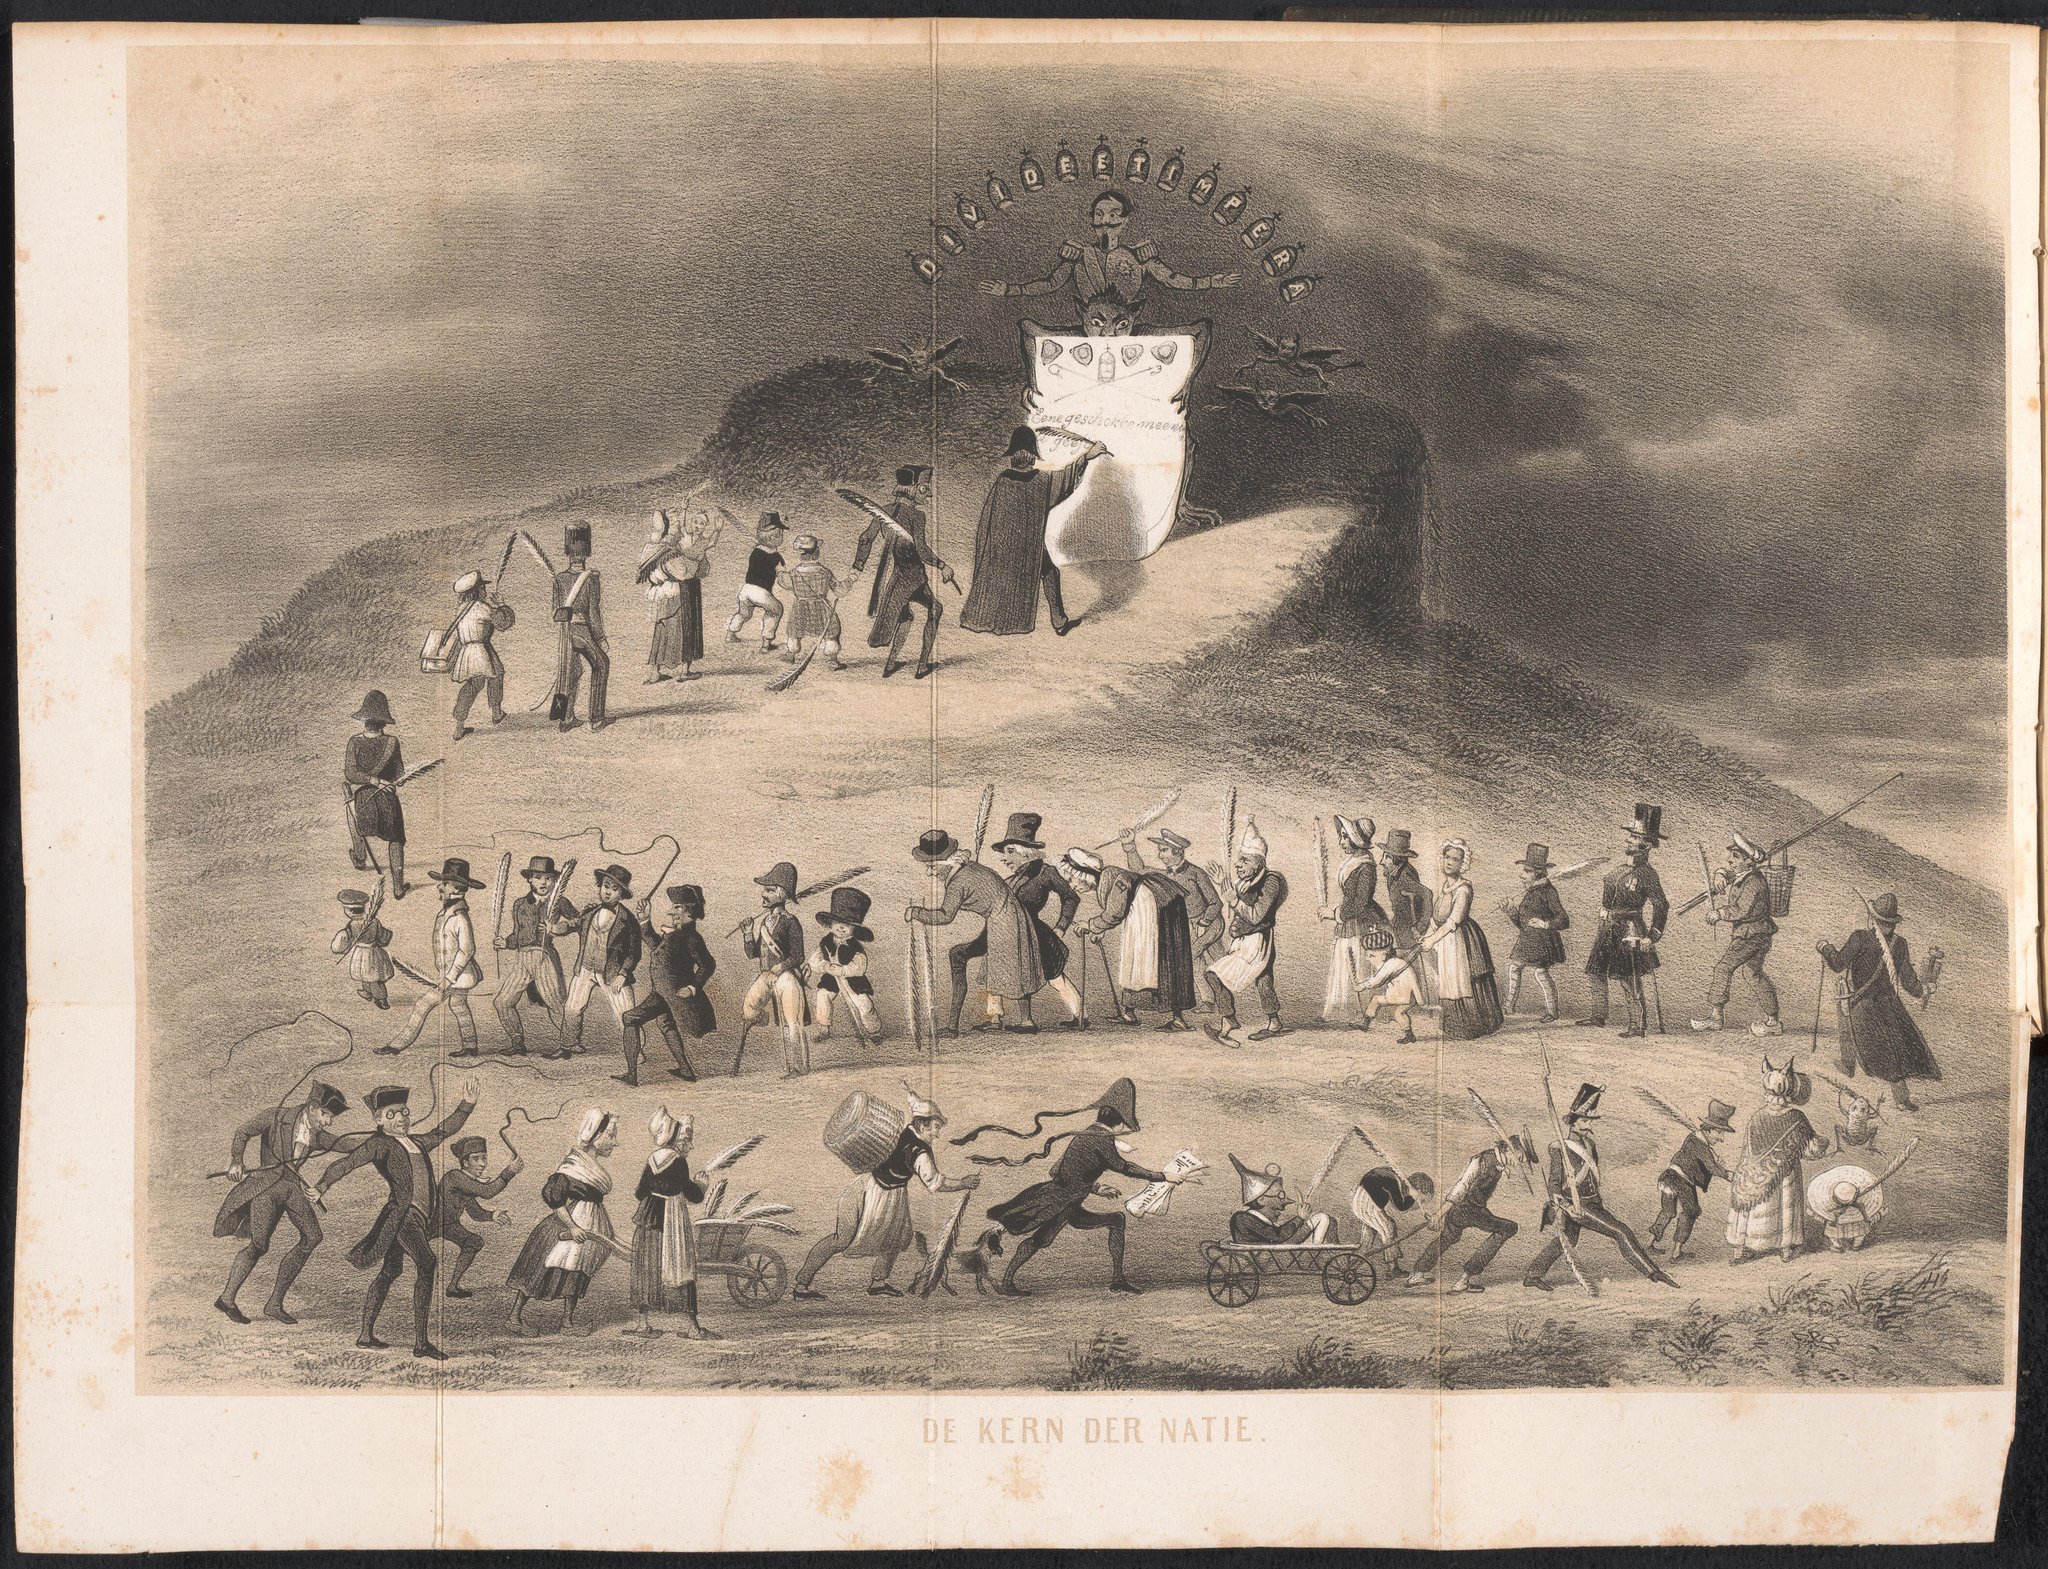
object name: print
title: Spotprent in Leidse studentenalmanak, 1854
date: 1854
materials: paper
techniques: tone lithography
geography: netherlands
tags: student life, leiden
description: Spotprent op de Aprilbeweging van 1853. Lange stoet van pelgrims met palmtakken op weg naar de heuveltop waar een officier met bisschopsmijters samen met de duivel wacht. Spotprent in de studentenalmanak van de Universiteit van Leiden van het jaar 1854.